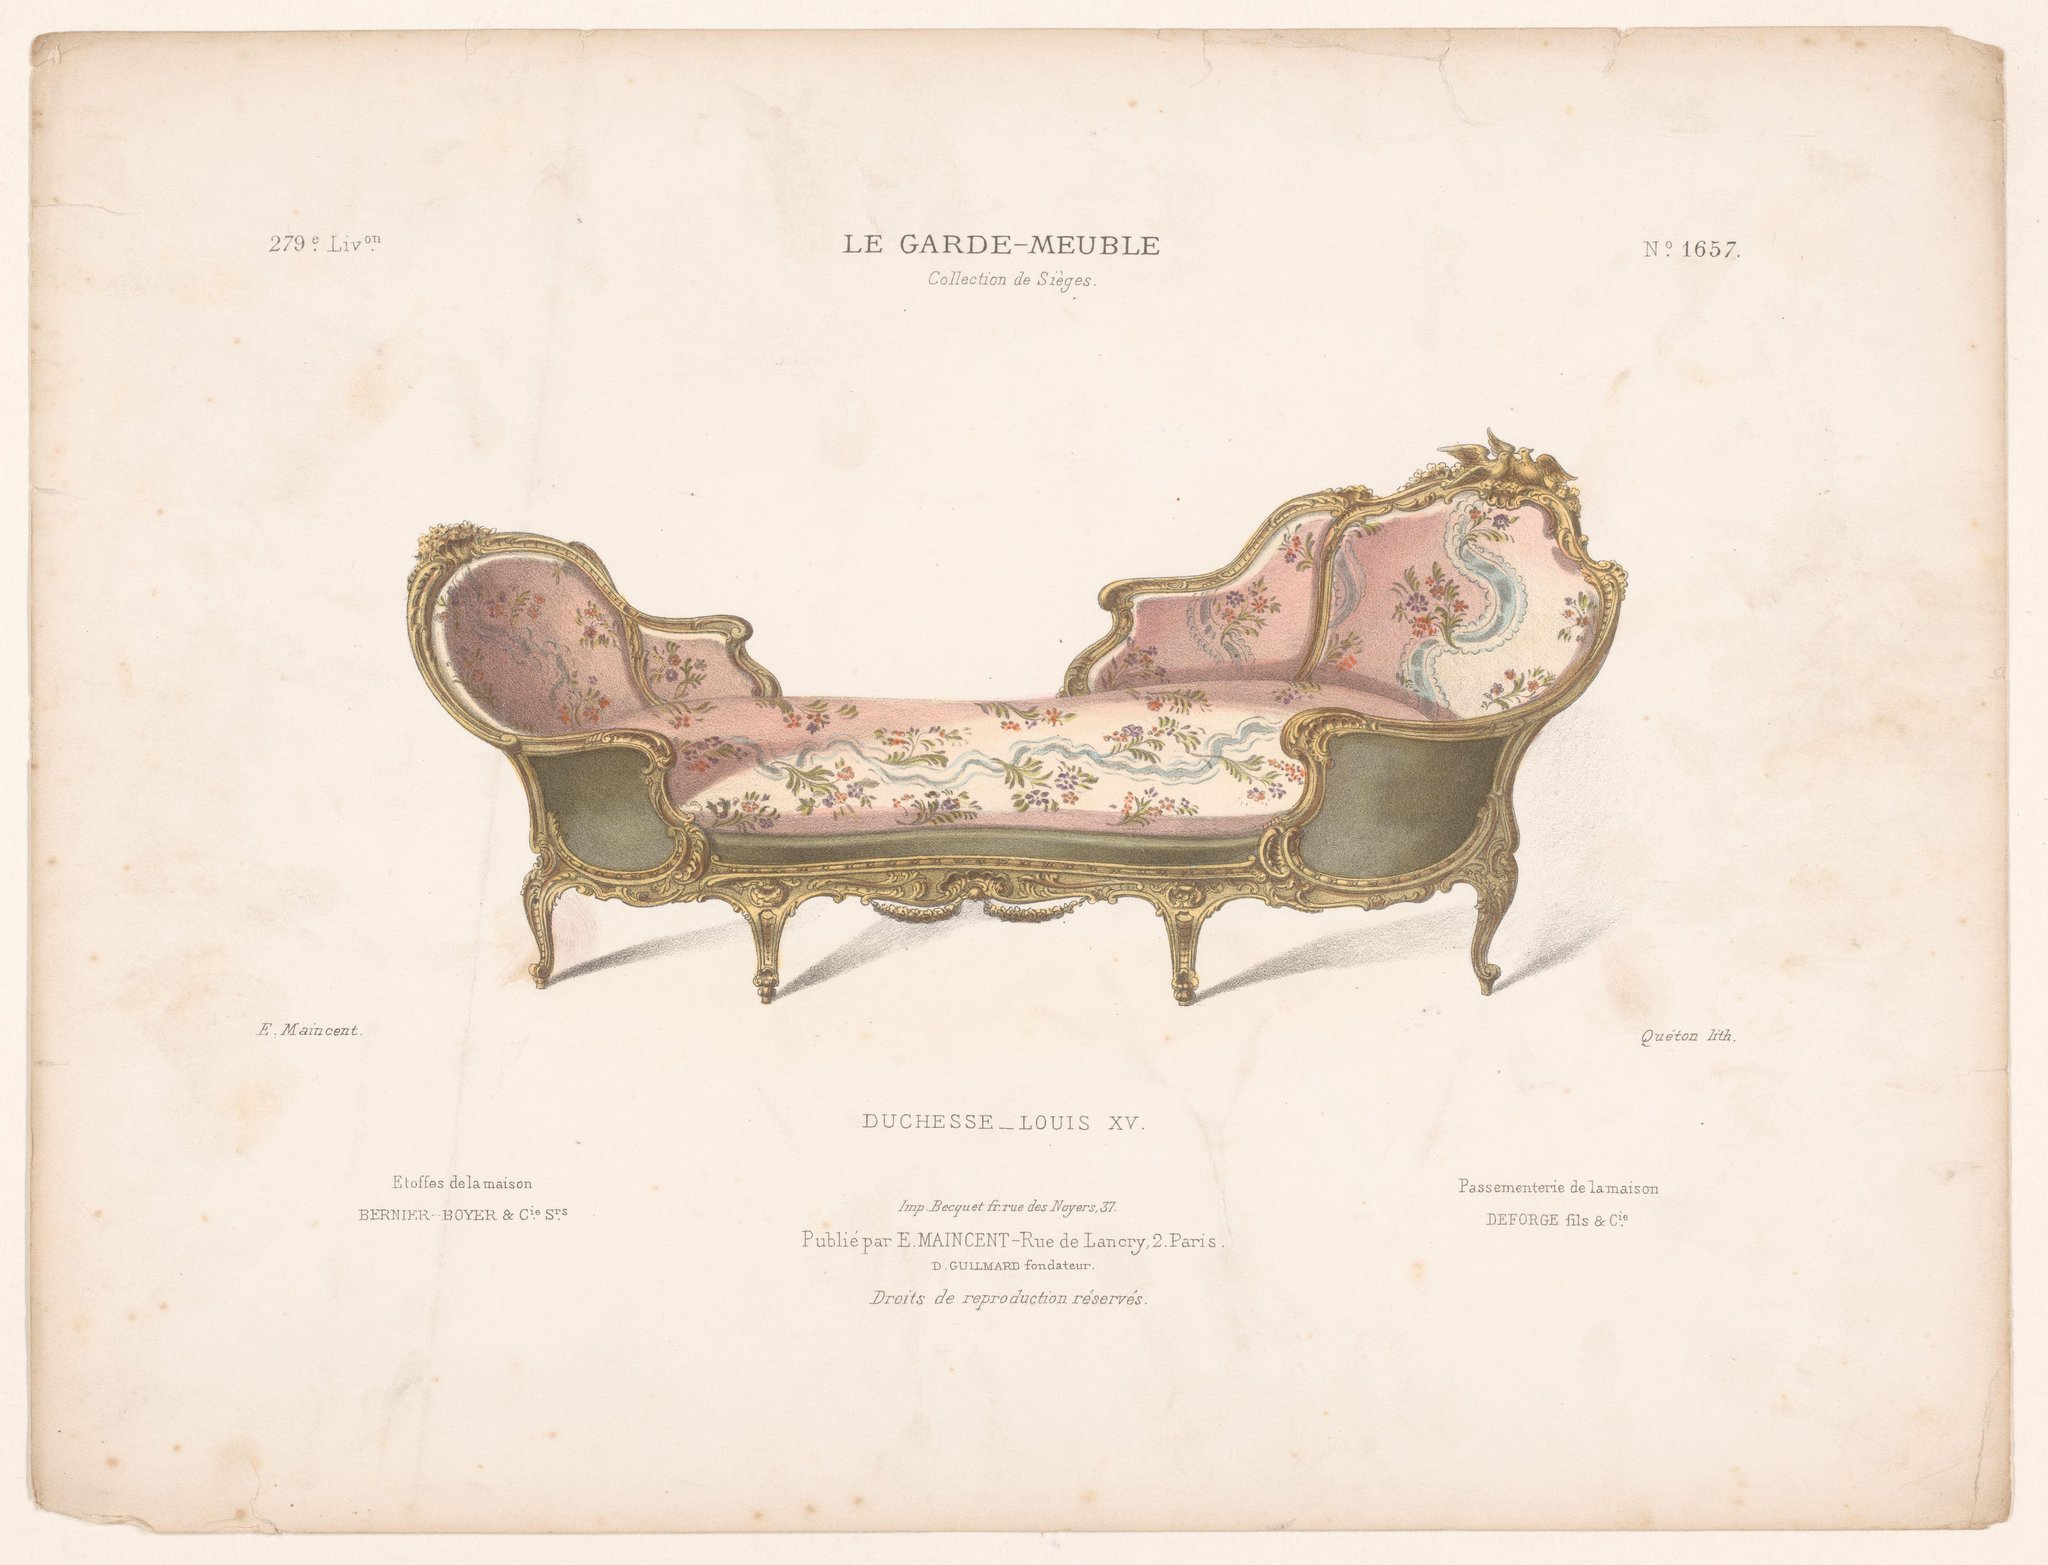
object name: print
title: Duchesse Louis XV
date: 1885-1895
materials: paper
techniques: hand coloring, lithograph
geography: paris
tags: seating furniture, mirror, table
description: Ieder Livraison in de serie Le Garde-Meuble bevat negen platen: drie 'sièges' (zitmeubels), drie 'meubles' (diverse meubels zoals tafels en kasten) en drie 'tentures' (gordijnen en draperieën).